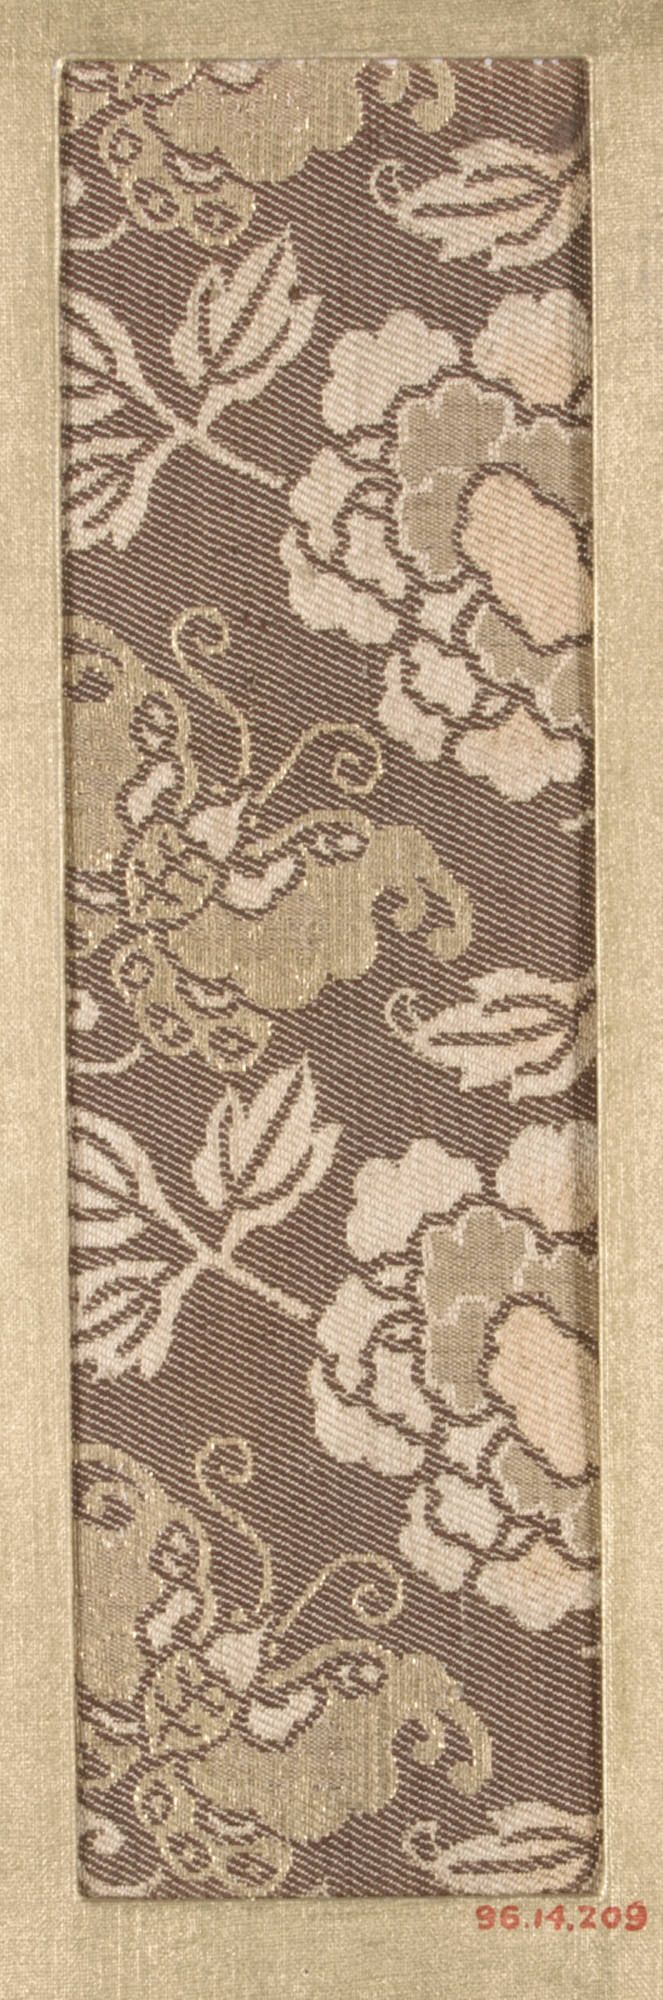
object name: piece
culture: japanese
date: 1701-1900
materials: silk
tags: butterflies,leaves